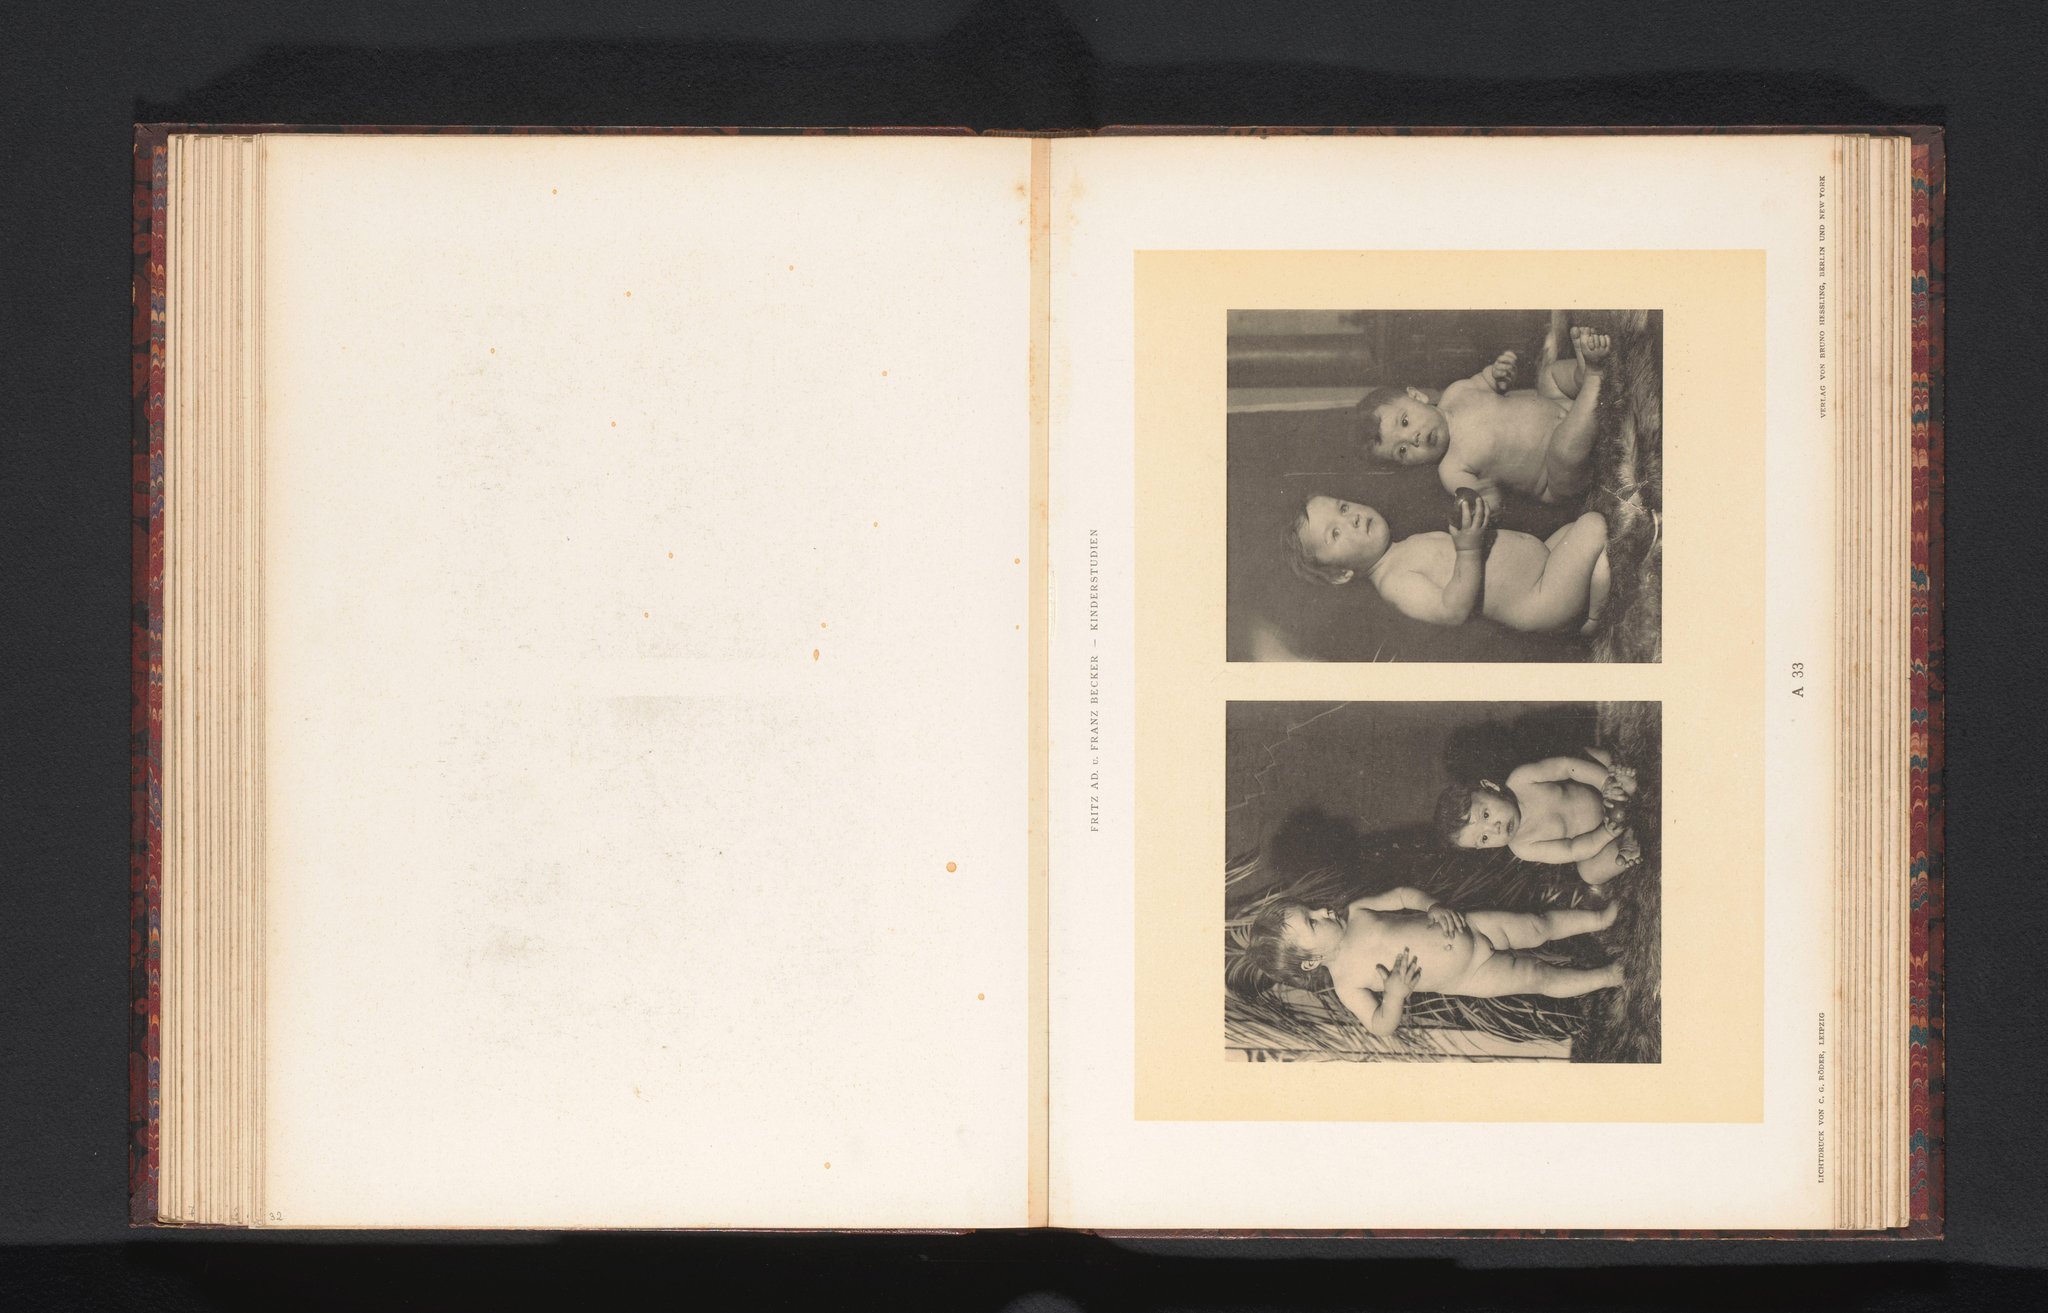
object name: page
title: Twee afbeeldingen van een naakt meisje en een naakte jongen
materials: paper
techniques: photograph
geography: leipzig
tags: toddler (male), toddler (female)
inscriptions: number: ‘A 33’